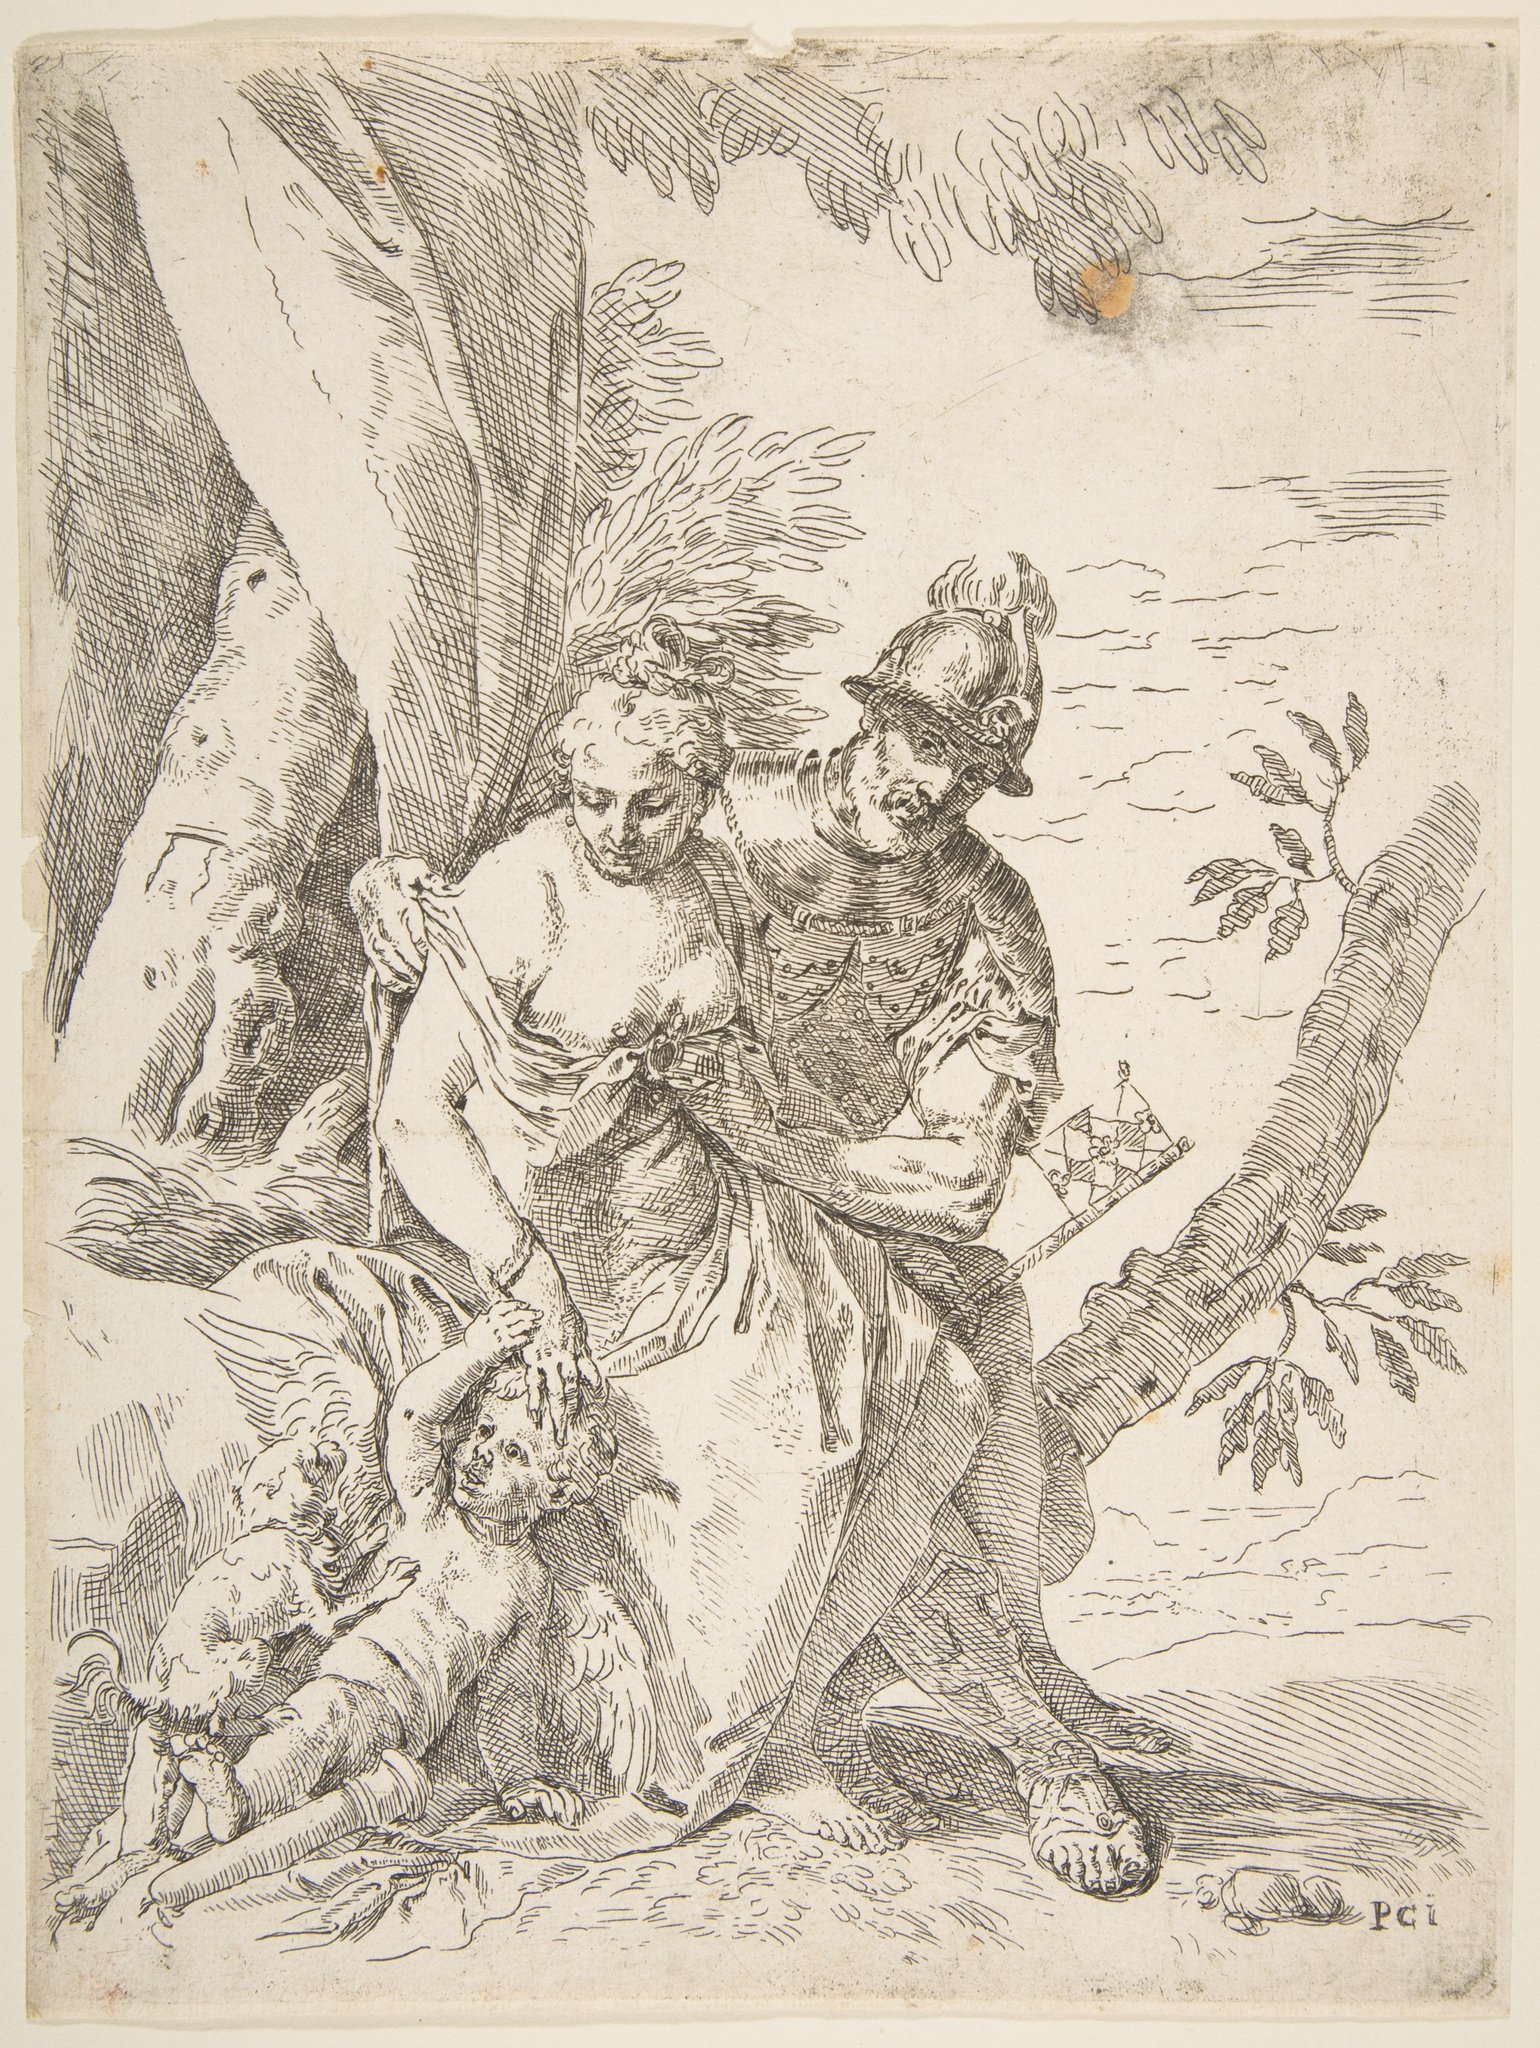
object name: print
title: Mars, Venus, and Cupid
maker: simone cantarini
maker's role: artist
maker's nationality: italian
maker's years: 1612-1648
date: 1637-1639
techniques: etching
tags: cupid,mars,venus,trees